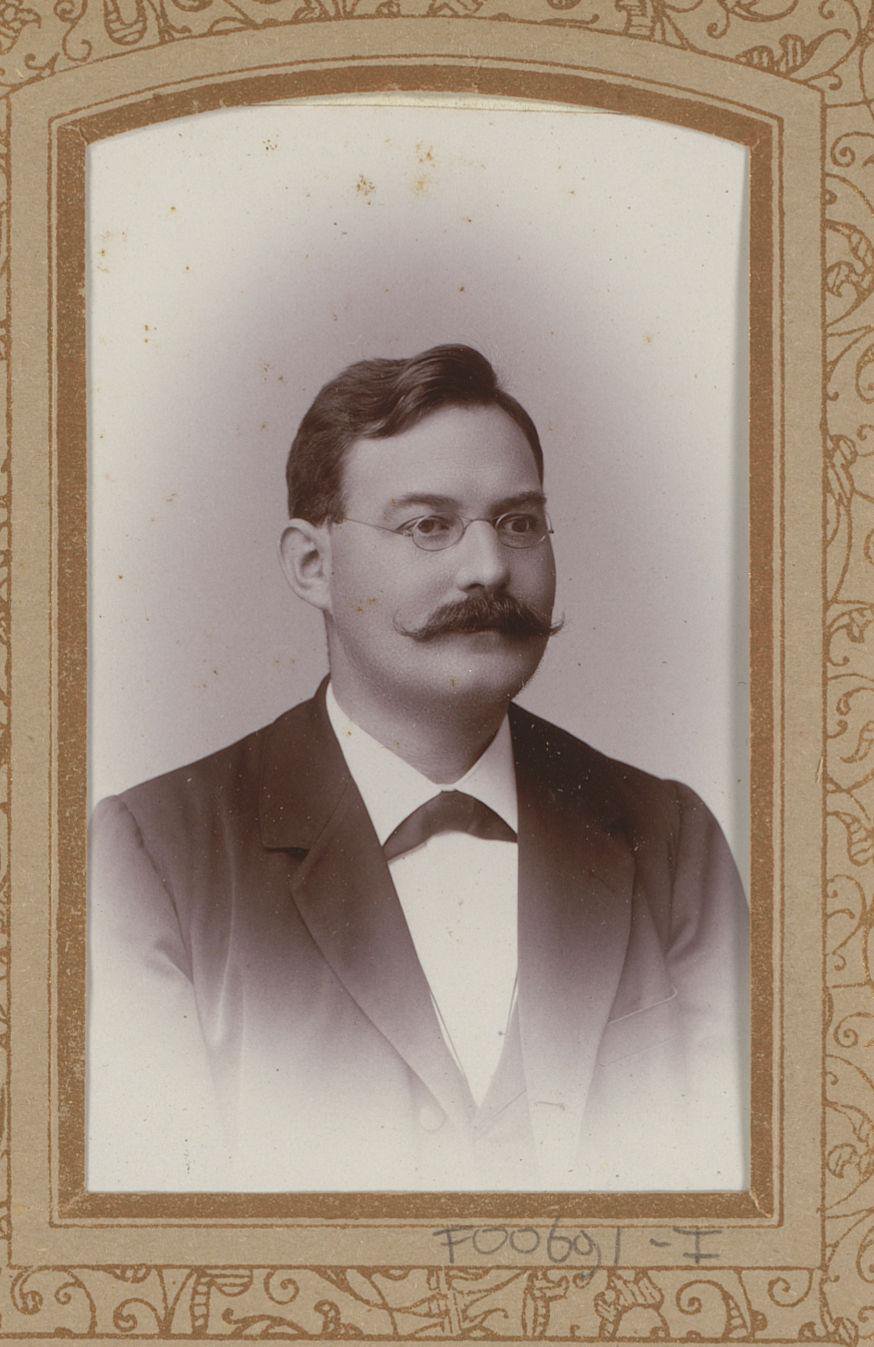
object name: photograph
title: Portret van een man, aangeduid als Gerard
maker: p. hermann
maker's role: fotograaf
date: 1900-1920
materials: cardboard, photographic support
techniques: collodion silver print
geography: buitenzorg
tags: historical persons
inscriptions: inscription: ‘P. Hermann/ Buitenzorg/ Java’, name: ‘Gerard’